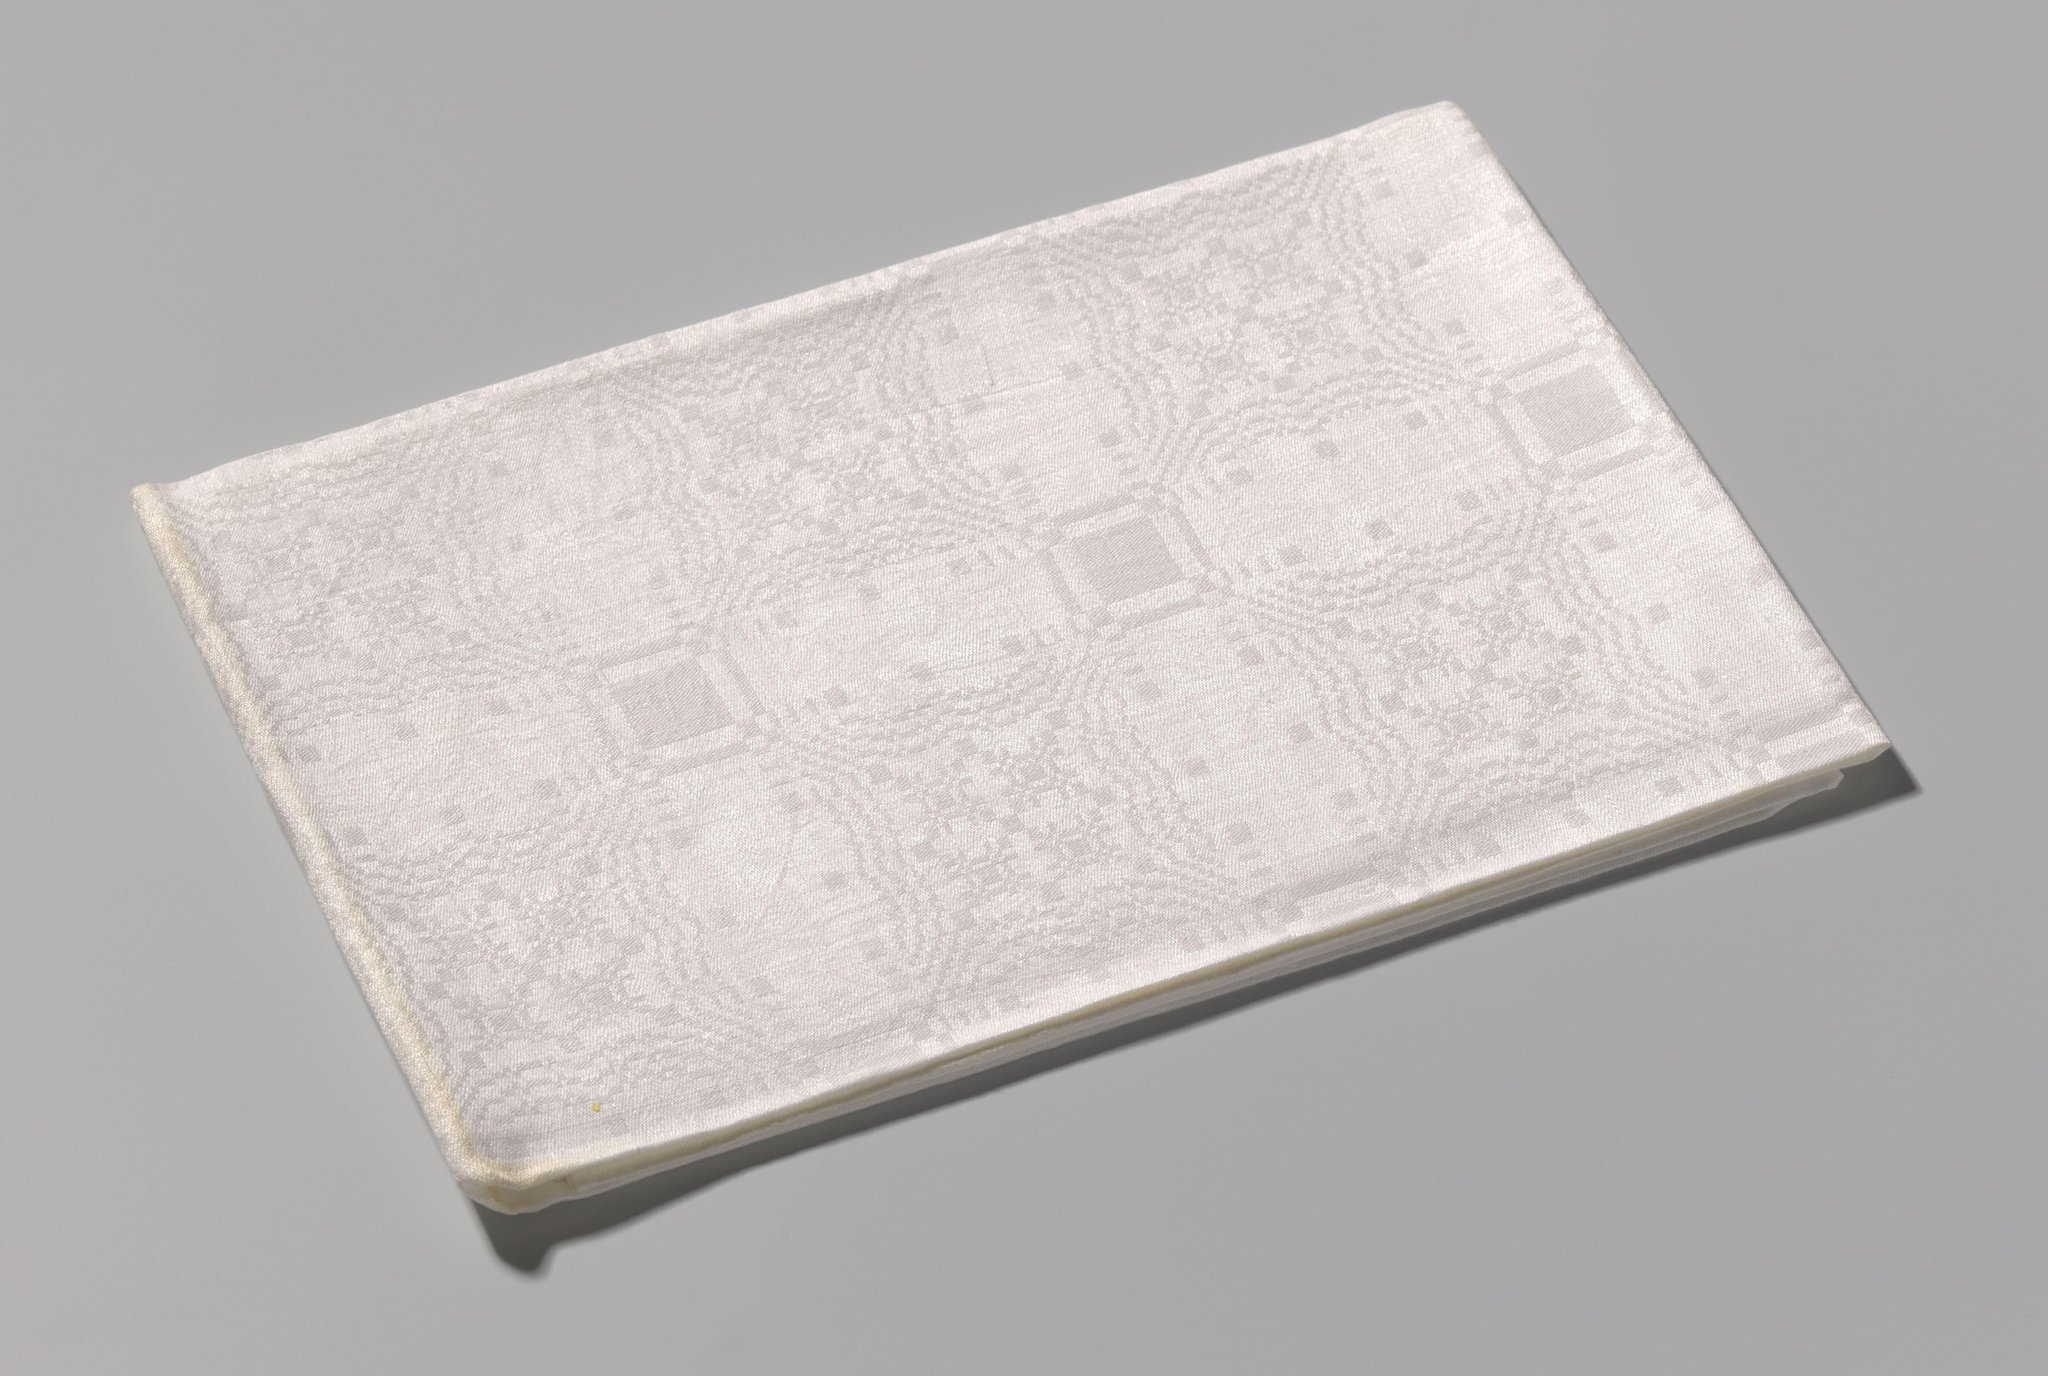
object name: towel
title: Handdoek van pellendamast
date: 1700-1800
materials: linen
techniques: weave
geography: northern netherlands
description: Handdoek van pellendamast. Effen banen met langs de zijden kleine vierkanten, kruisen elkaar. Op de kruispunten grote vierkanten. De ruimtes tussen de snijpunten zijn gevuld met lijnen en blokken. De randen zijn gestreept. De handdoek hoort bij twee handdoeken (BK-1977-355-A t/m BK-1977-355-C).